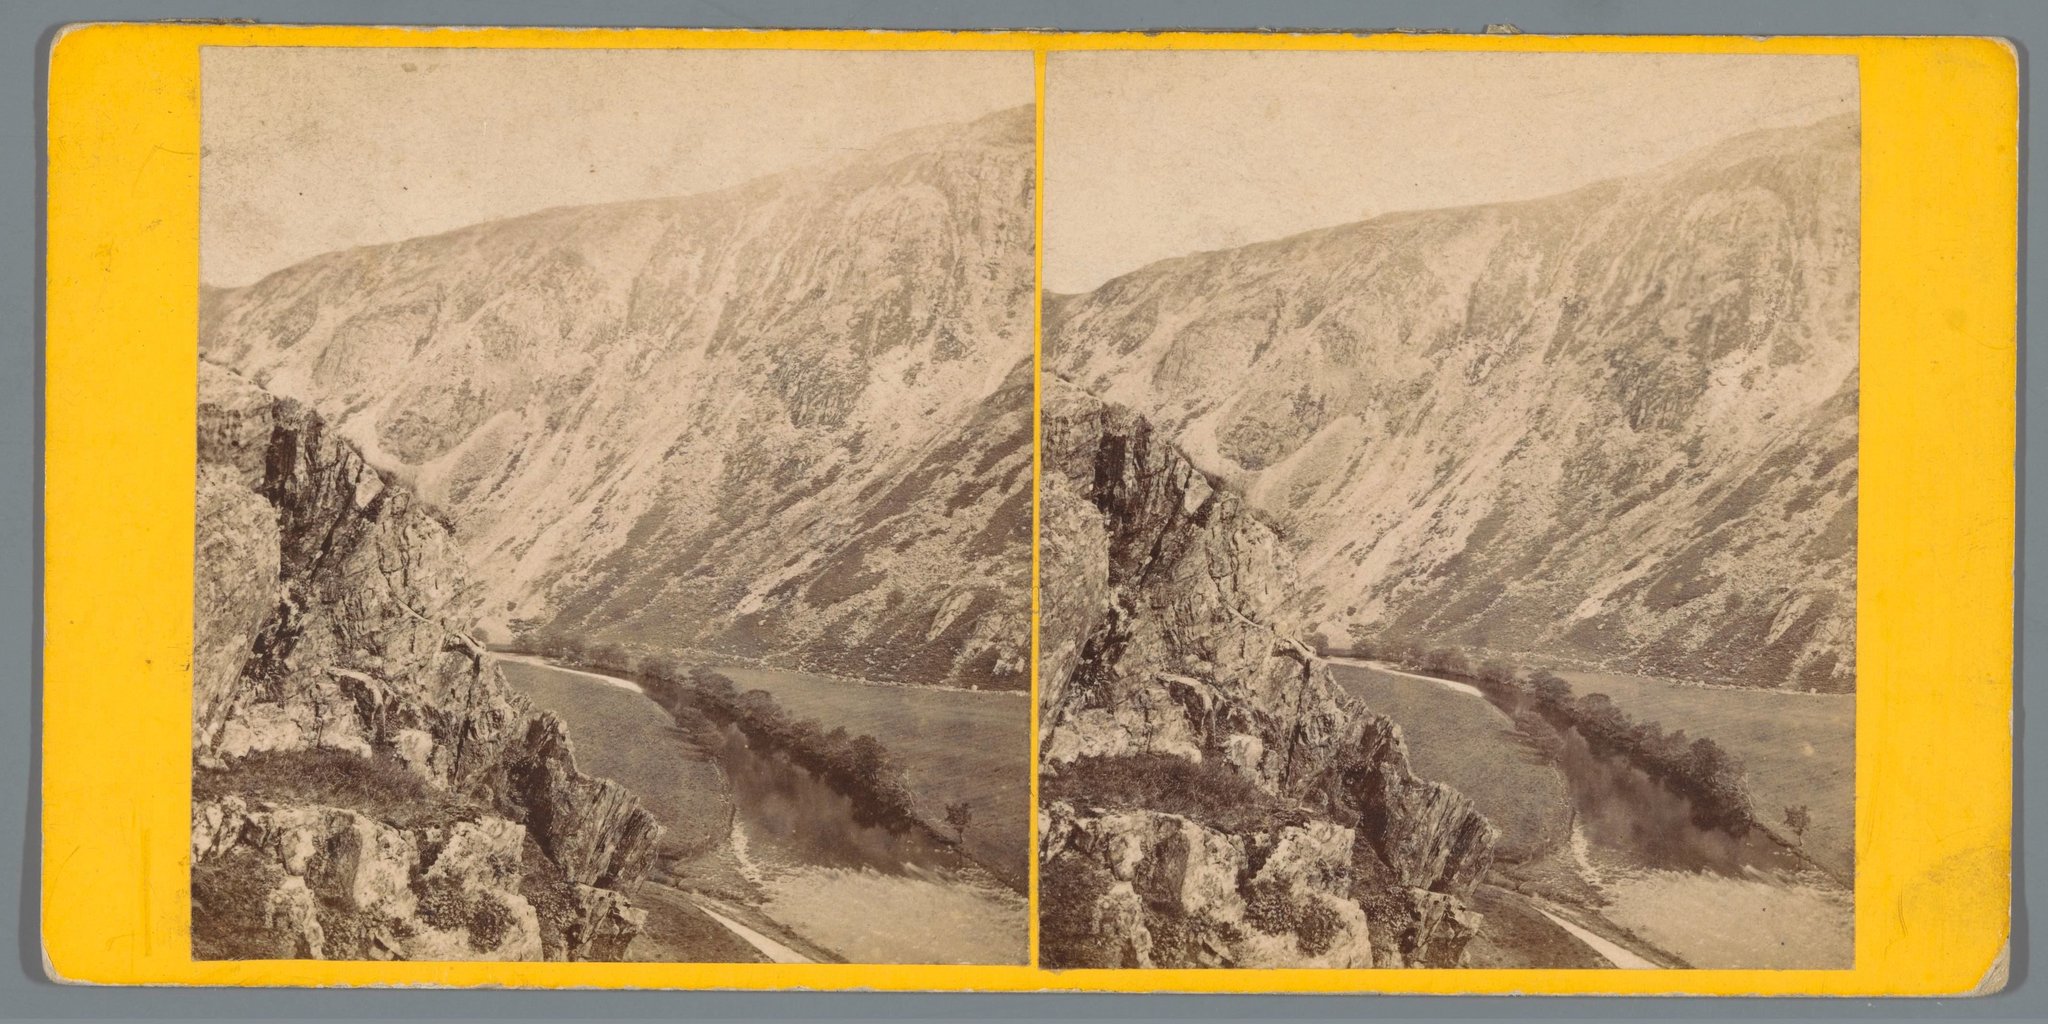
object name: stereograph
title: Glen Almond – The Small Glenn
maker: george washington wilson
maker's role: publisher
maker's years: 1823-1893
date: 1860-1865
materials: cardboard, photographic support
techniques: albumen print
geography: aberdeen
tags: schotland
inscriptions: label: ‘G.W. Wilson & Co, Aberdeen No. 501 Glen Almond – The Small Glenn’